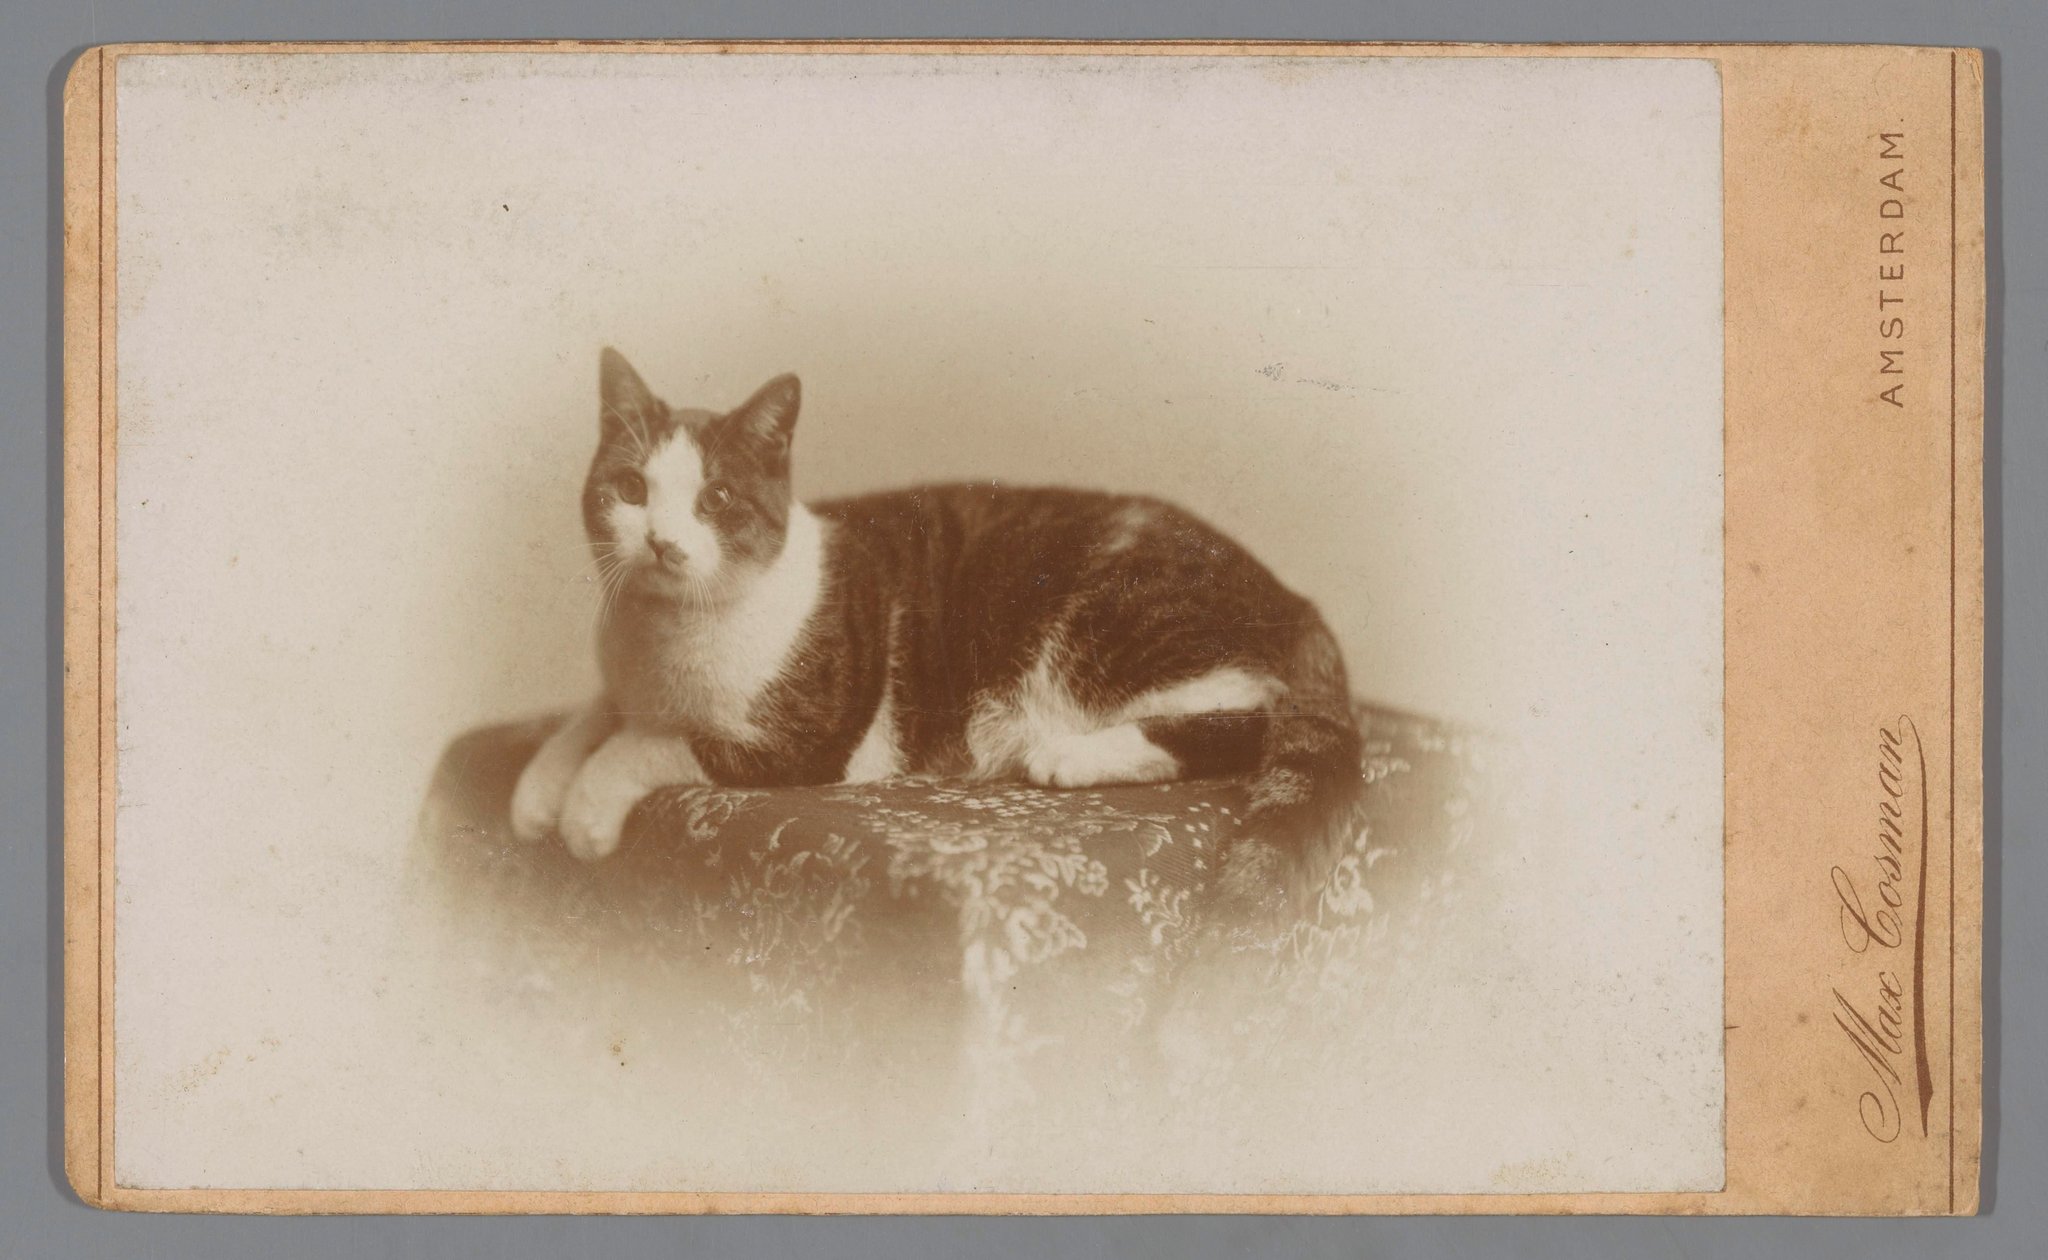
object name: cabinet photograph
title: Kat op een kussen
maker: max cosman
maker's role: fotograaf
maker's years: 1852-1894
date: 1881-1903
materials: cardboard, photographic support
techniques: collodion silver print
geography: amsterdam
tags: cat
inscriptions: name: ‘Photographisch Atelier Max Cosman Galerij 48 Amsterdam. De plaat blyft voor nabestelling bewaard. Specialiteit in vergrootingen.’